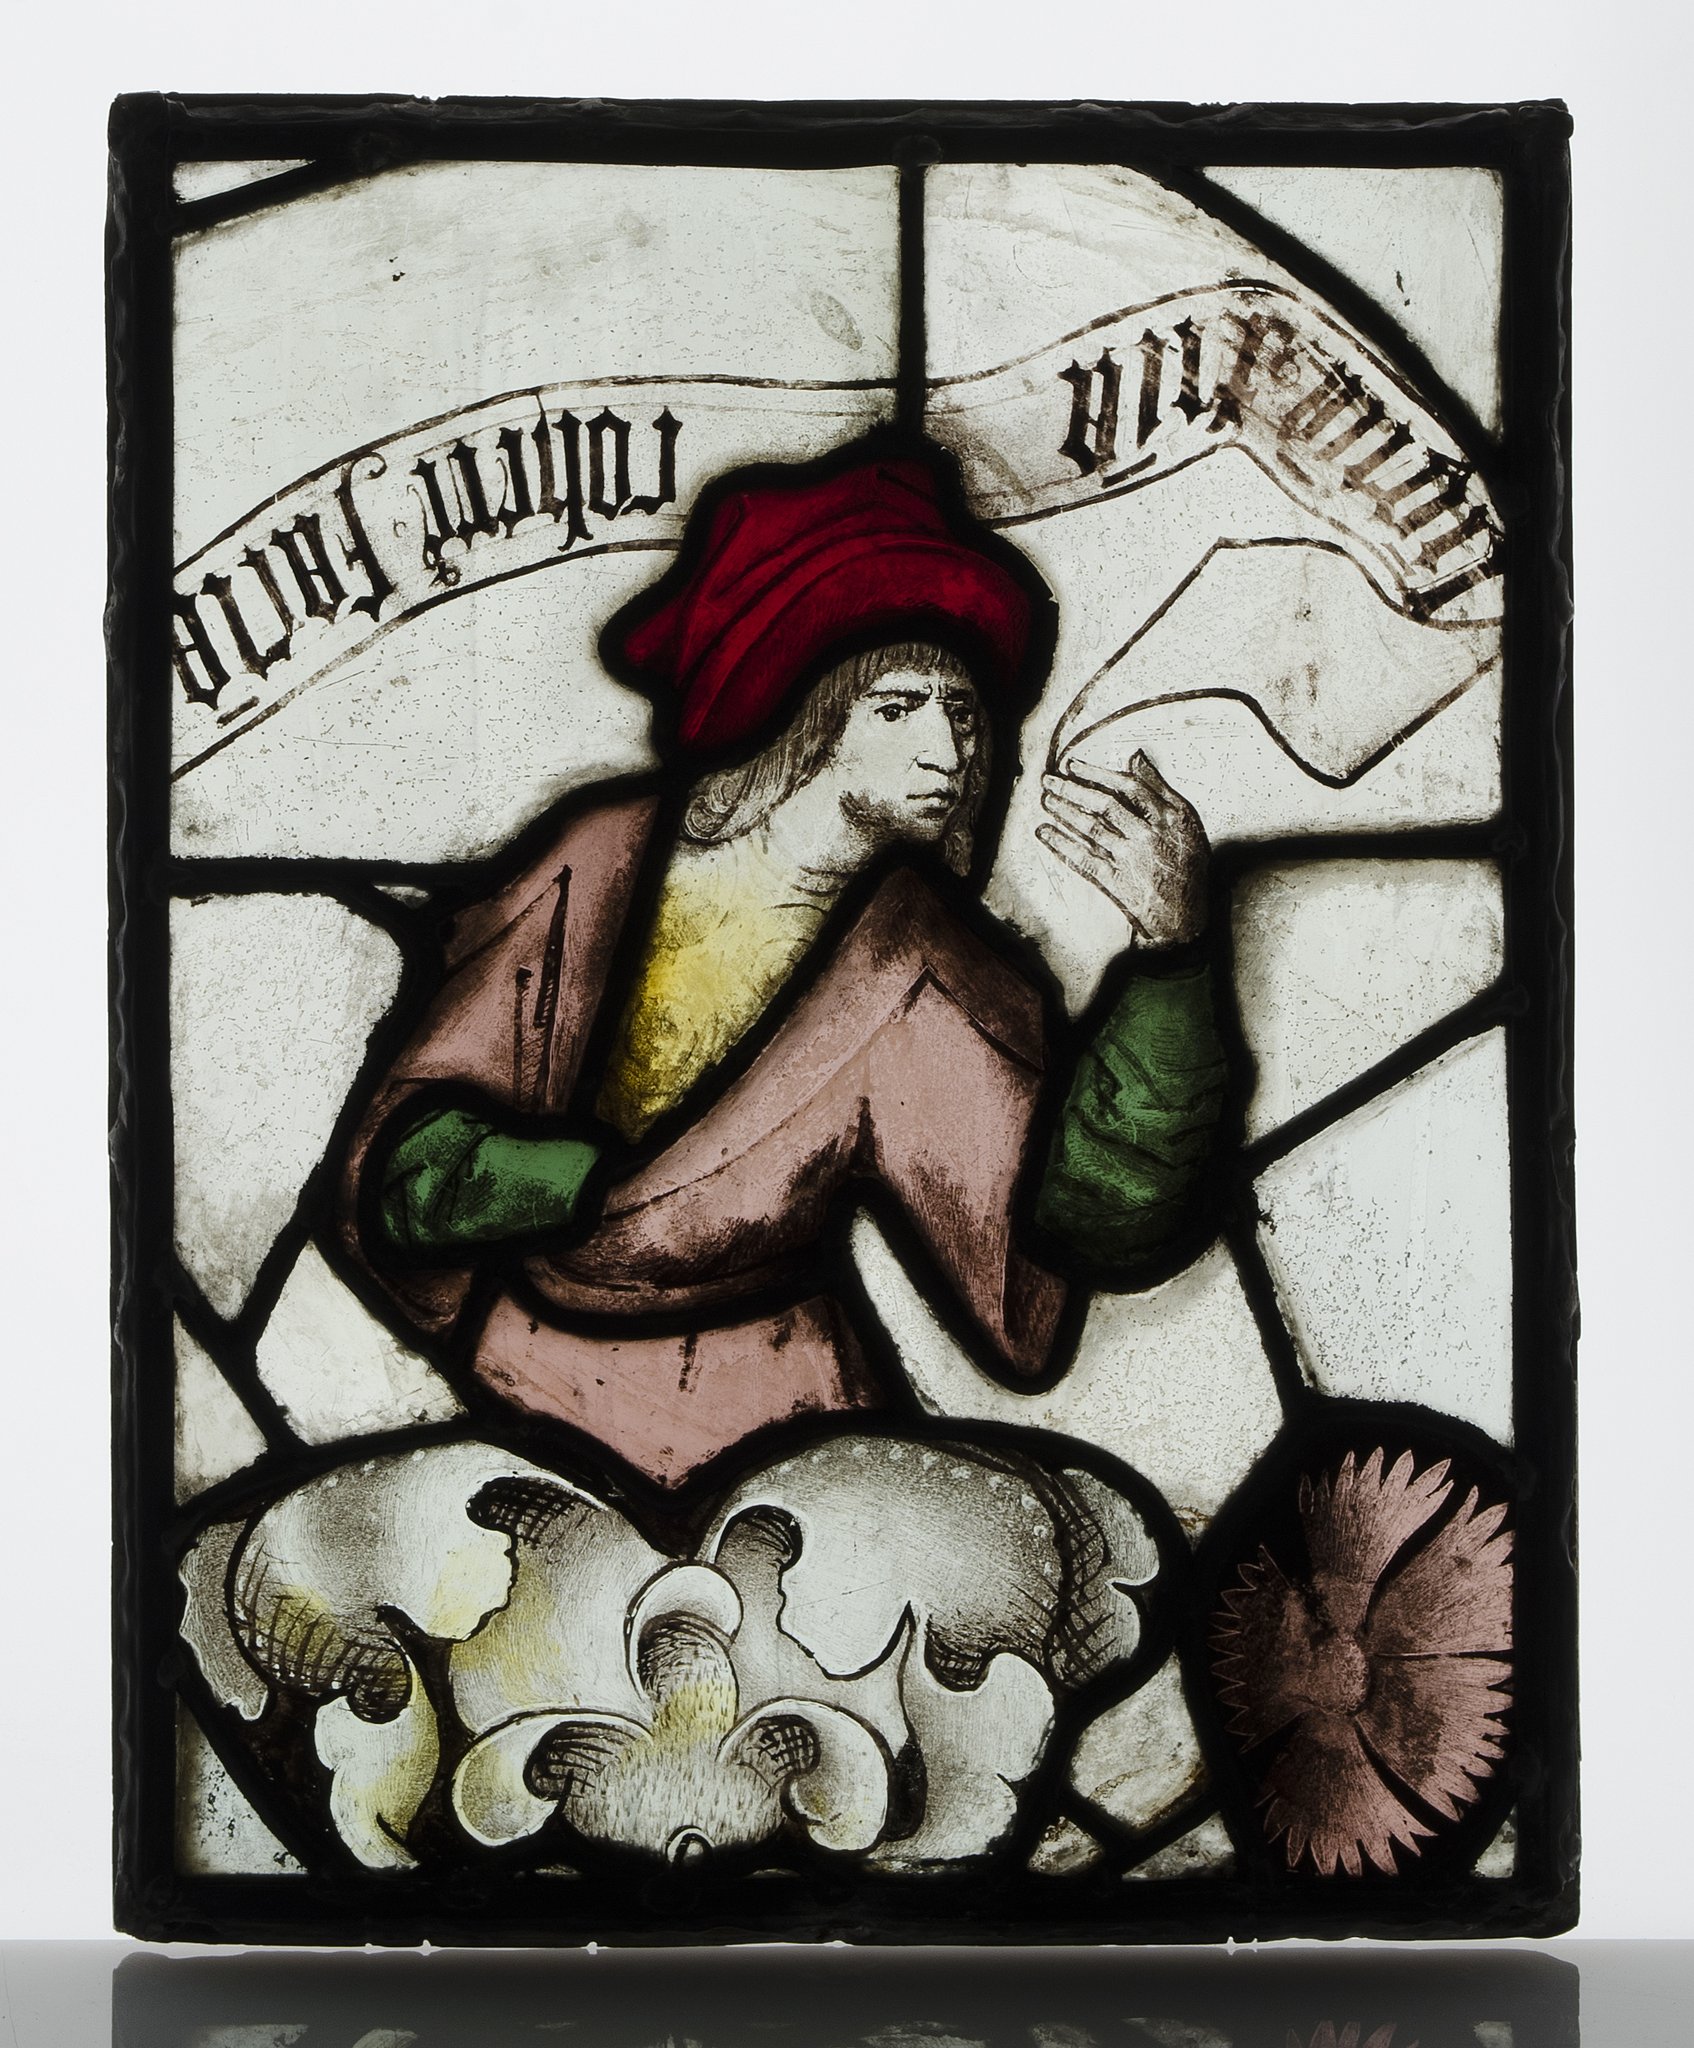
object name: panel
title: The Prophet Ezechiel, from a Tree of Jesse Window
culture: british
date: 1434-1466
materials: glass, metal, paint